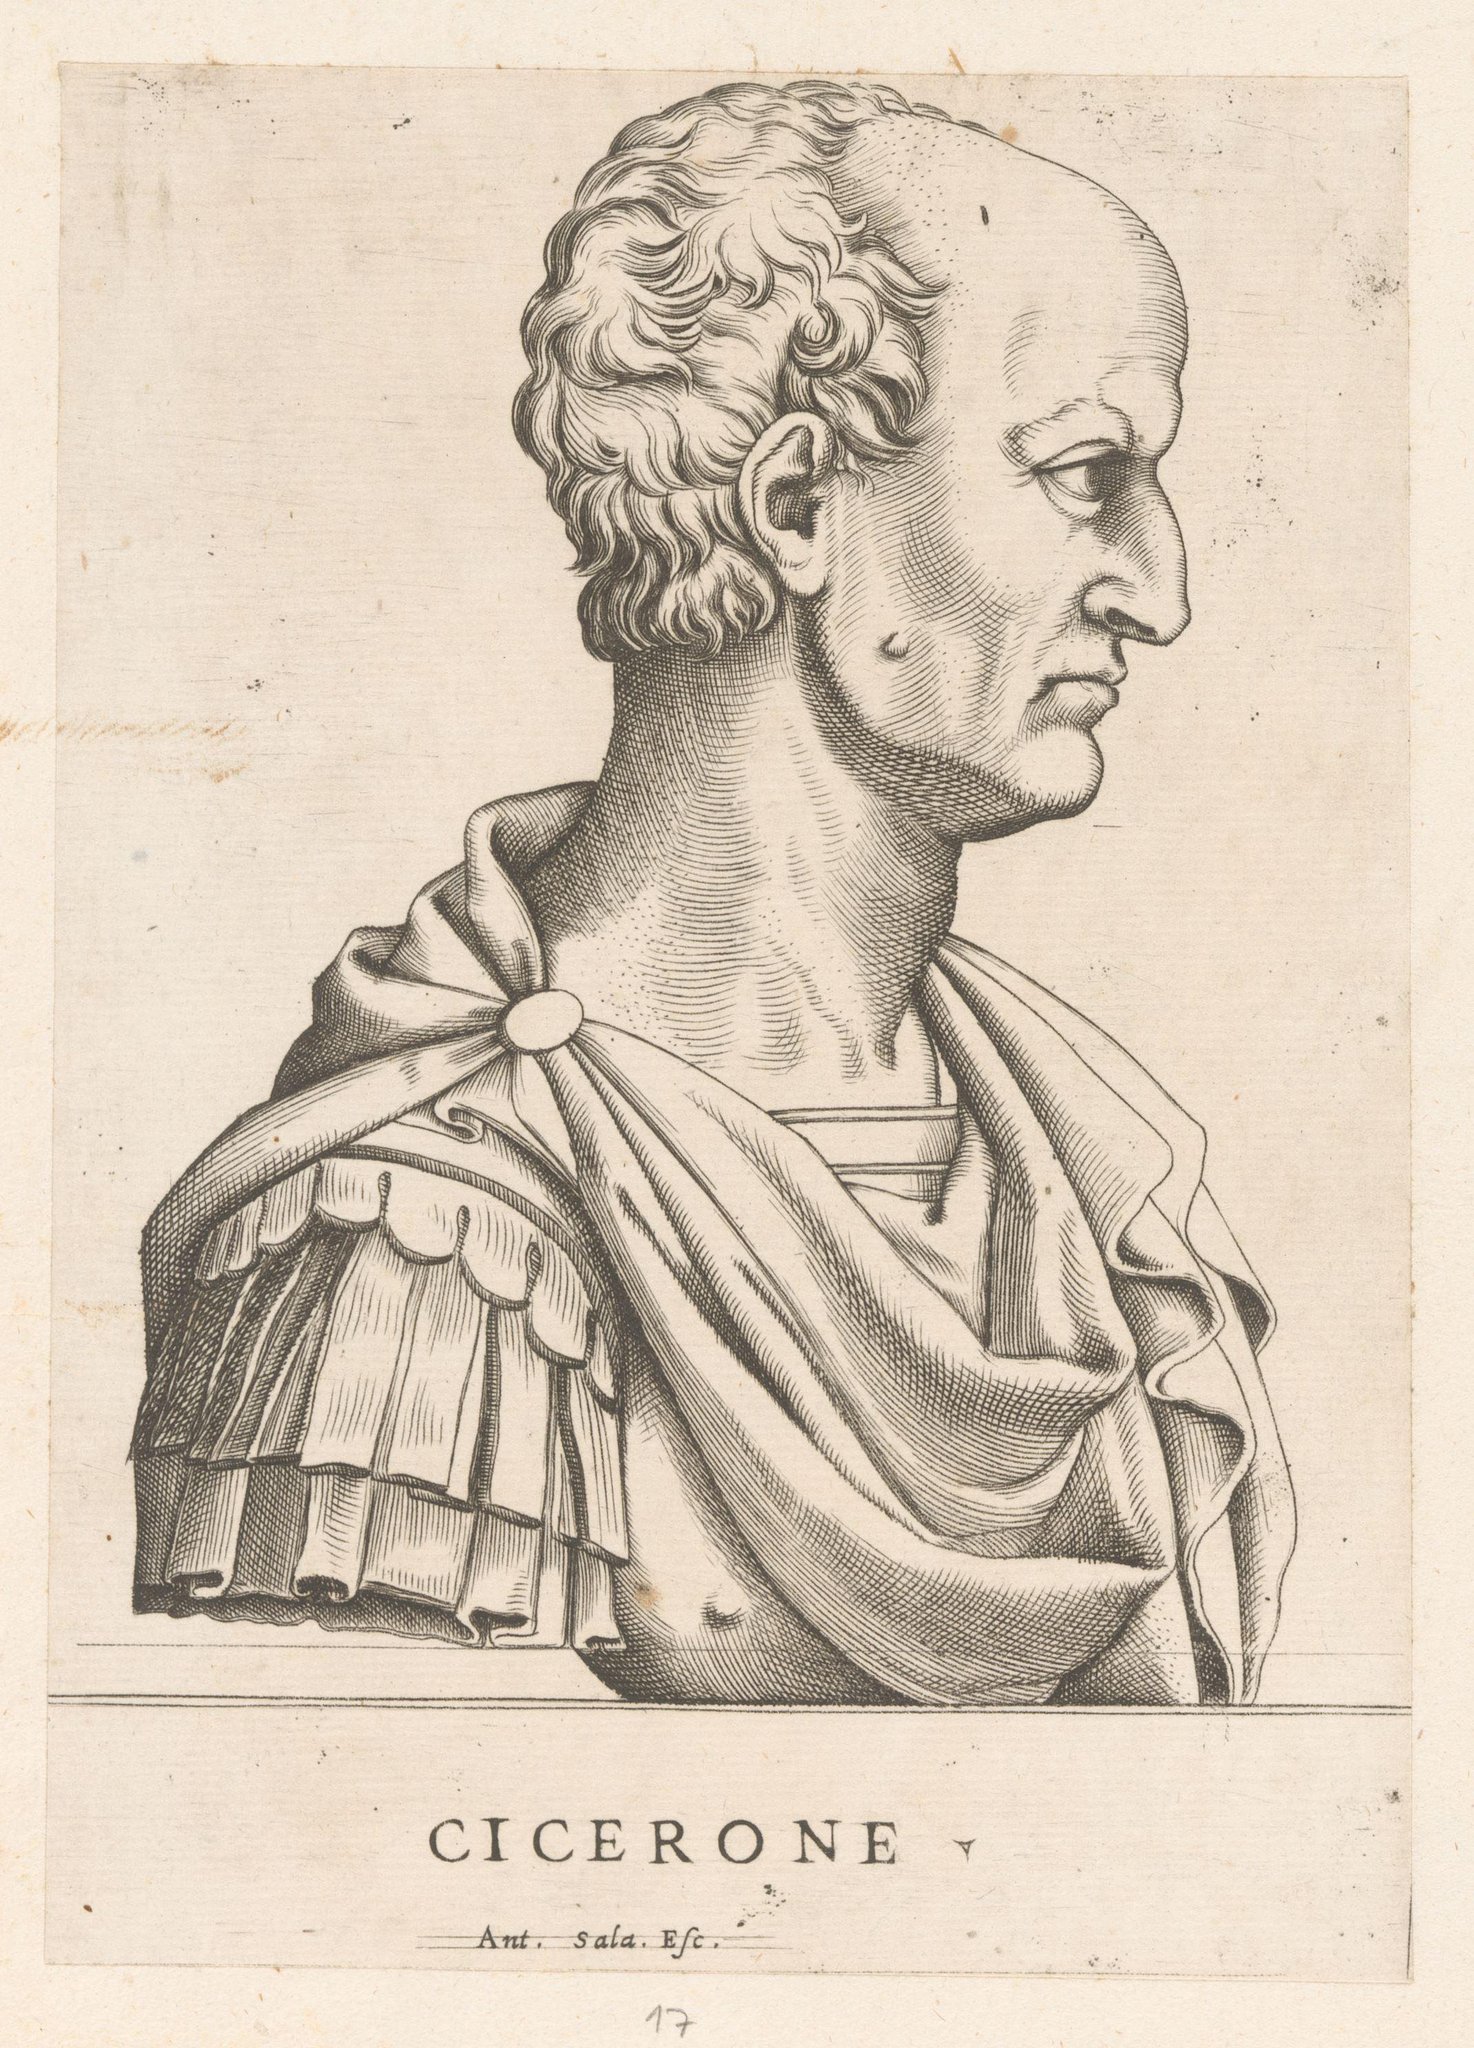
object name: print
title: Portretbuste van filosoof Cicero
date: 1510-1562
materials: paper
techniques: engraving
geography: italy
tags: marcus tullius cicero, scholar, philosopher, historical persons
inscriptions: collector's mark: Lugt 11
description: Samen met RP-P-H-OB-207.756 op één opzetvel geplakt.